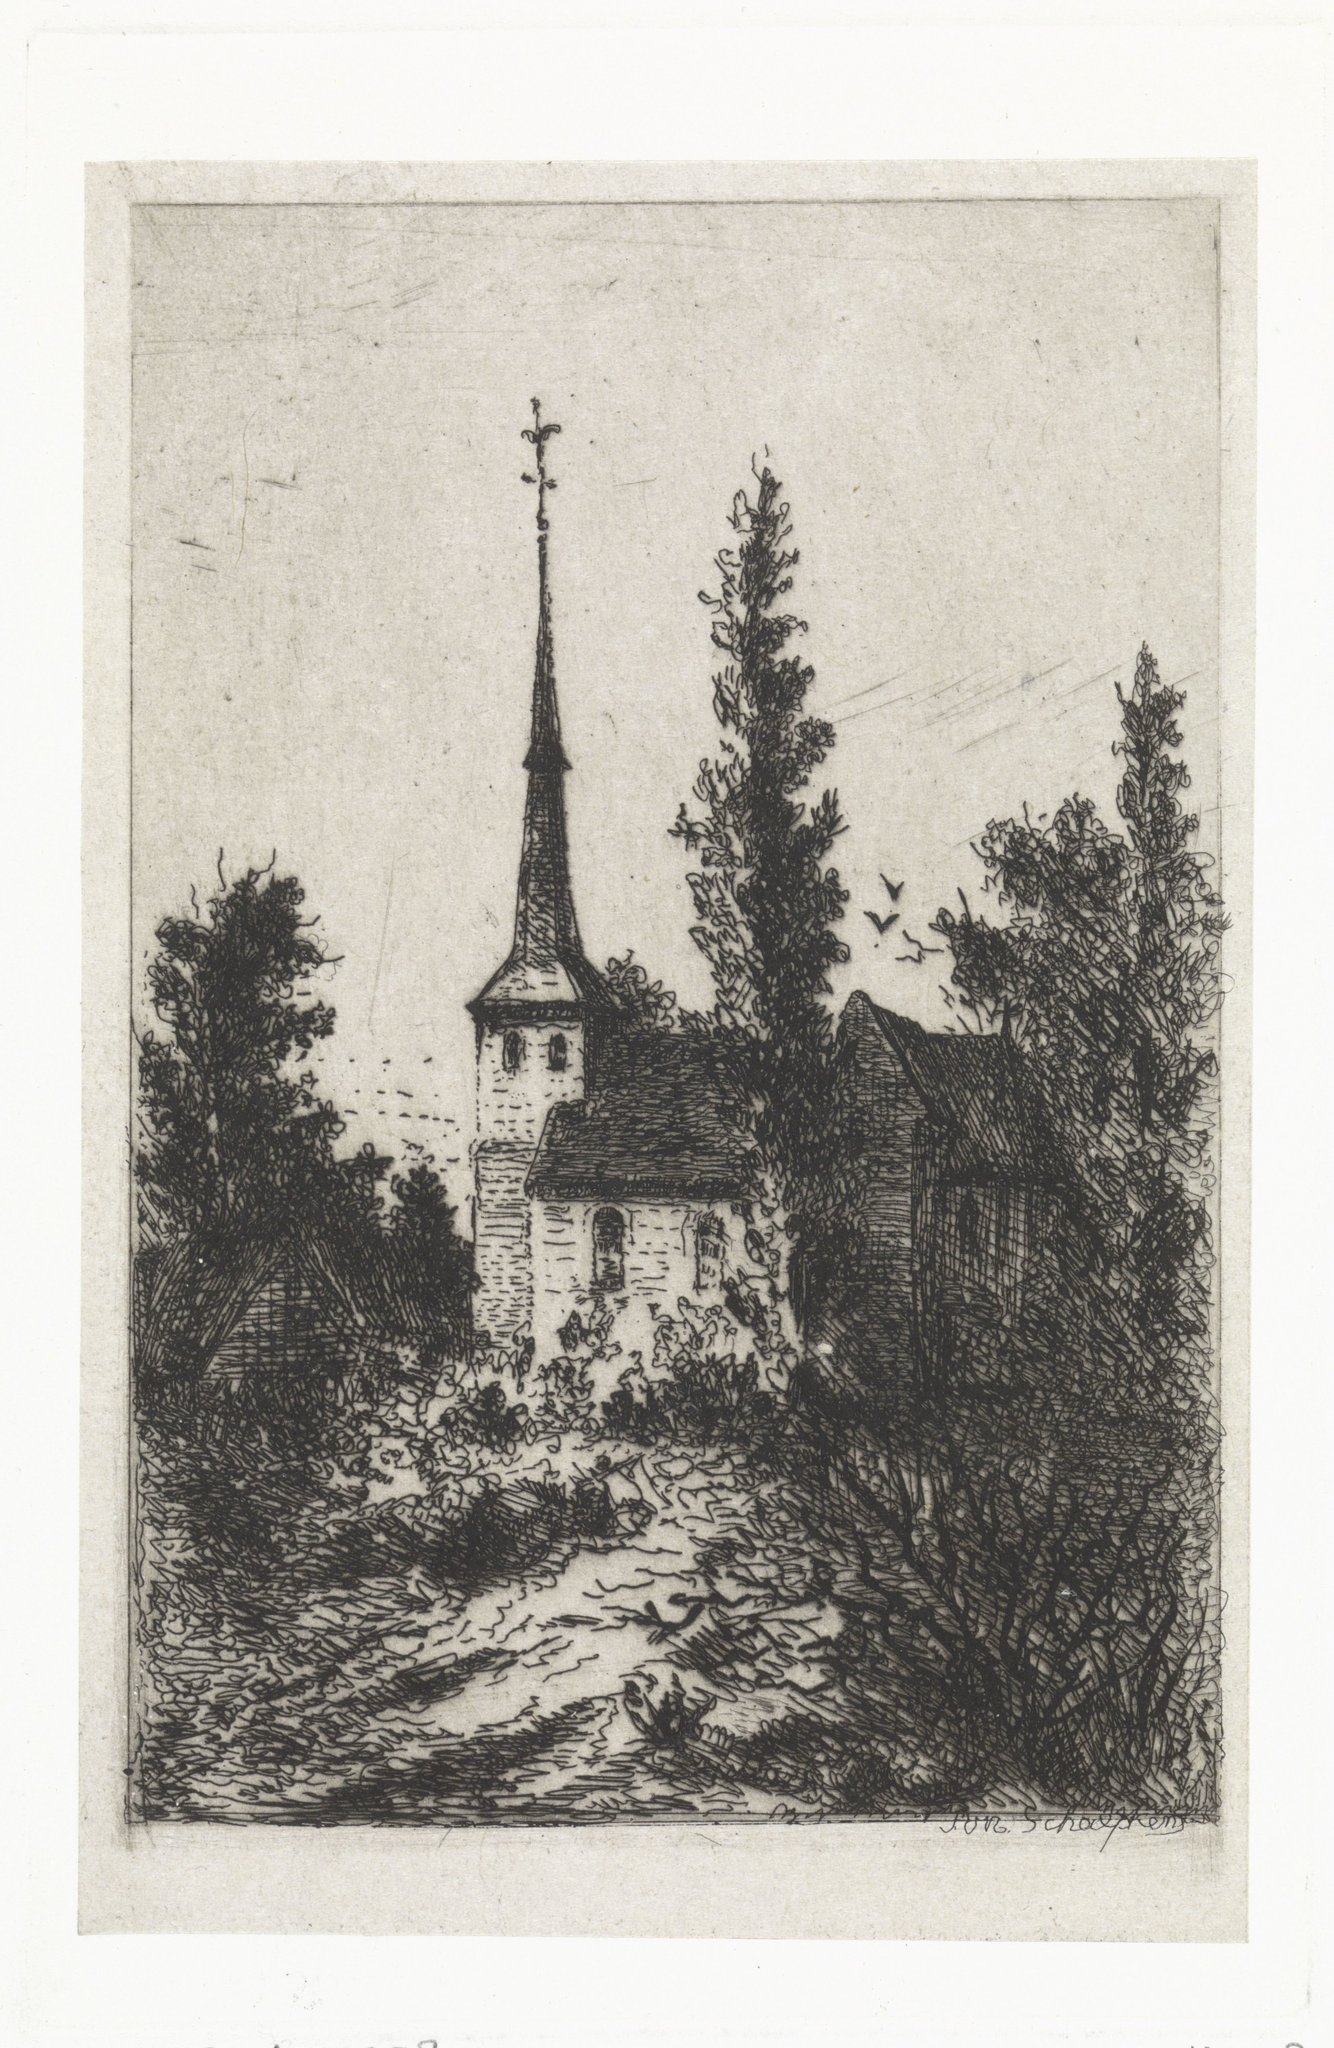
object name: print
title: Kerk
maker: arnoud schaepkens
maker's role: print maker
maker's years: 1816-1904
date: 1831-1888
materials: paper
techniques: drypoint, etching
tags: church (exterior)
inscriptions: collector's mark: Lugt 2228